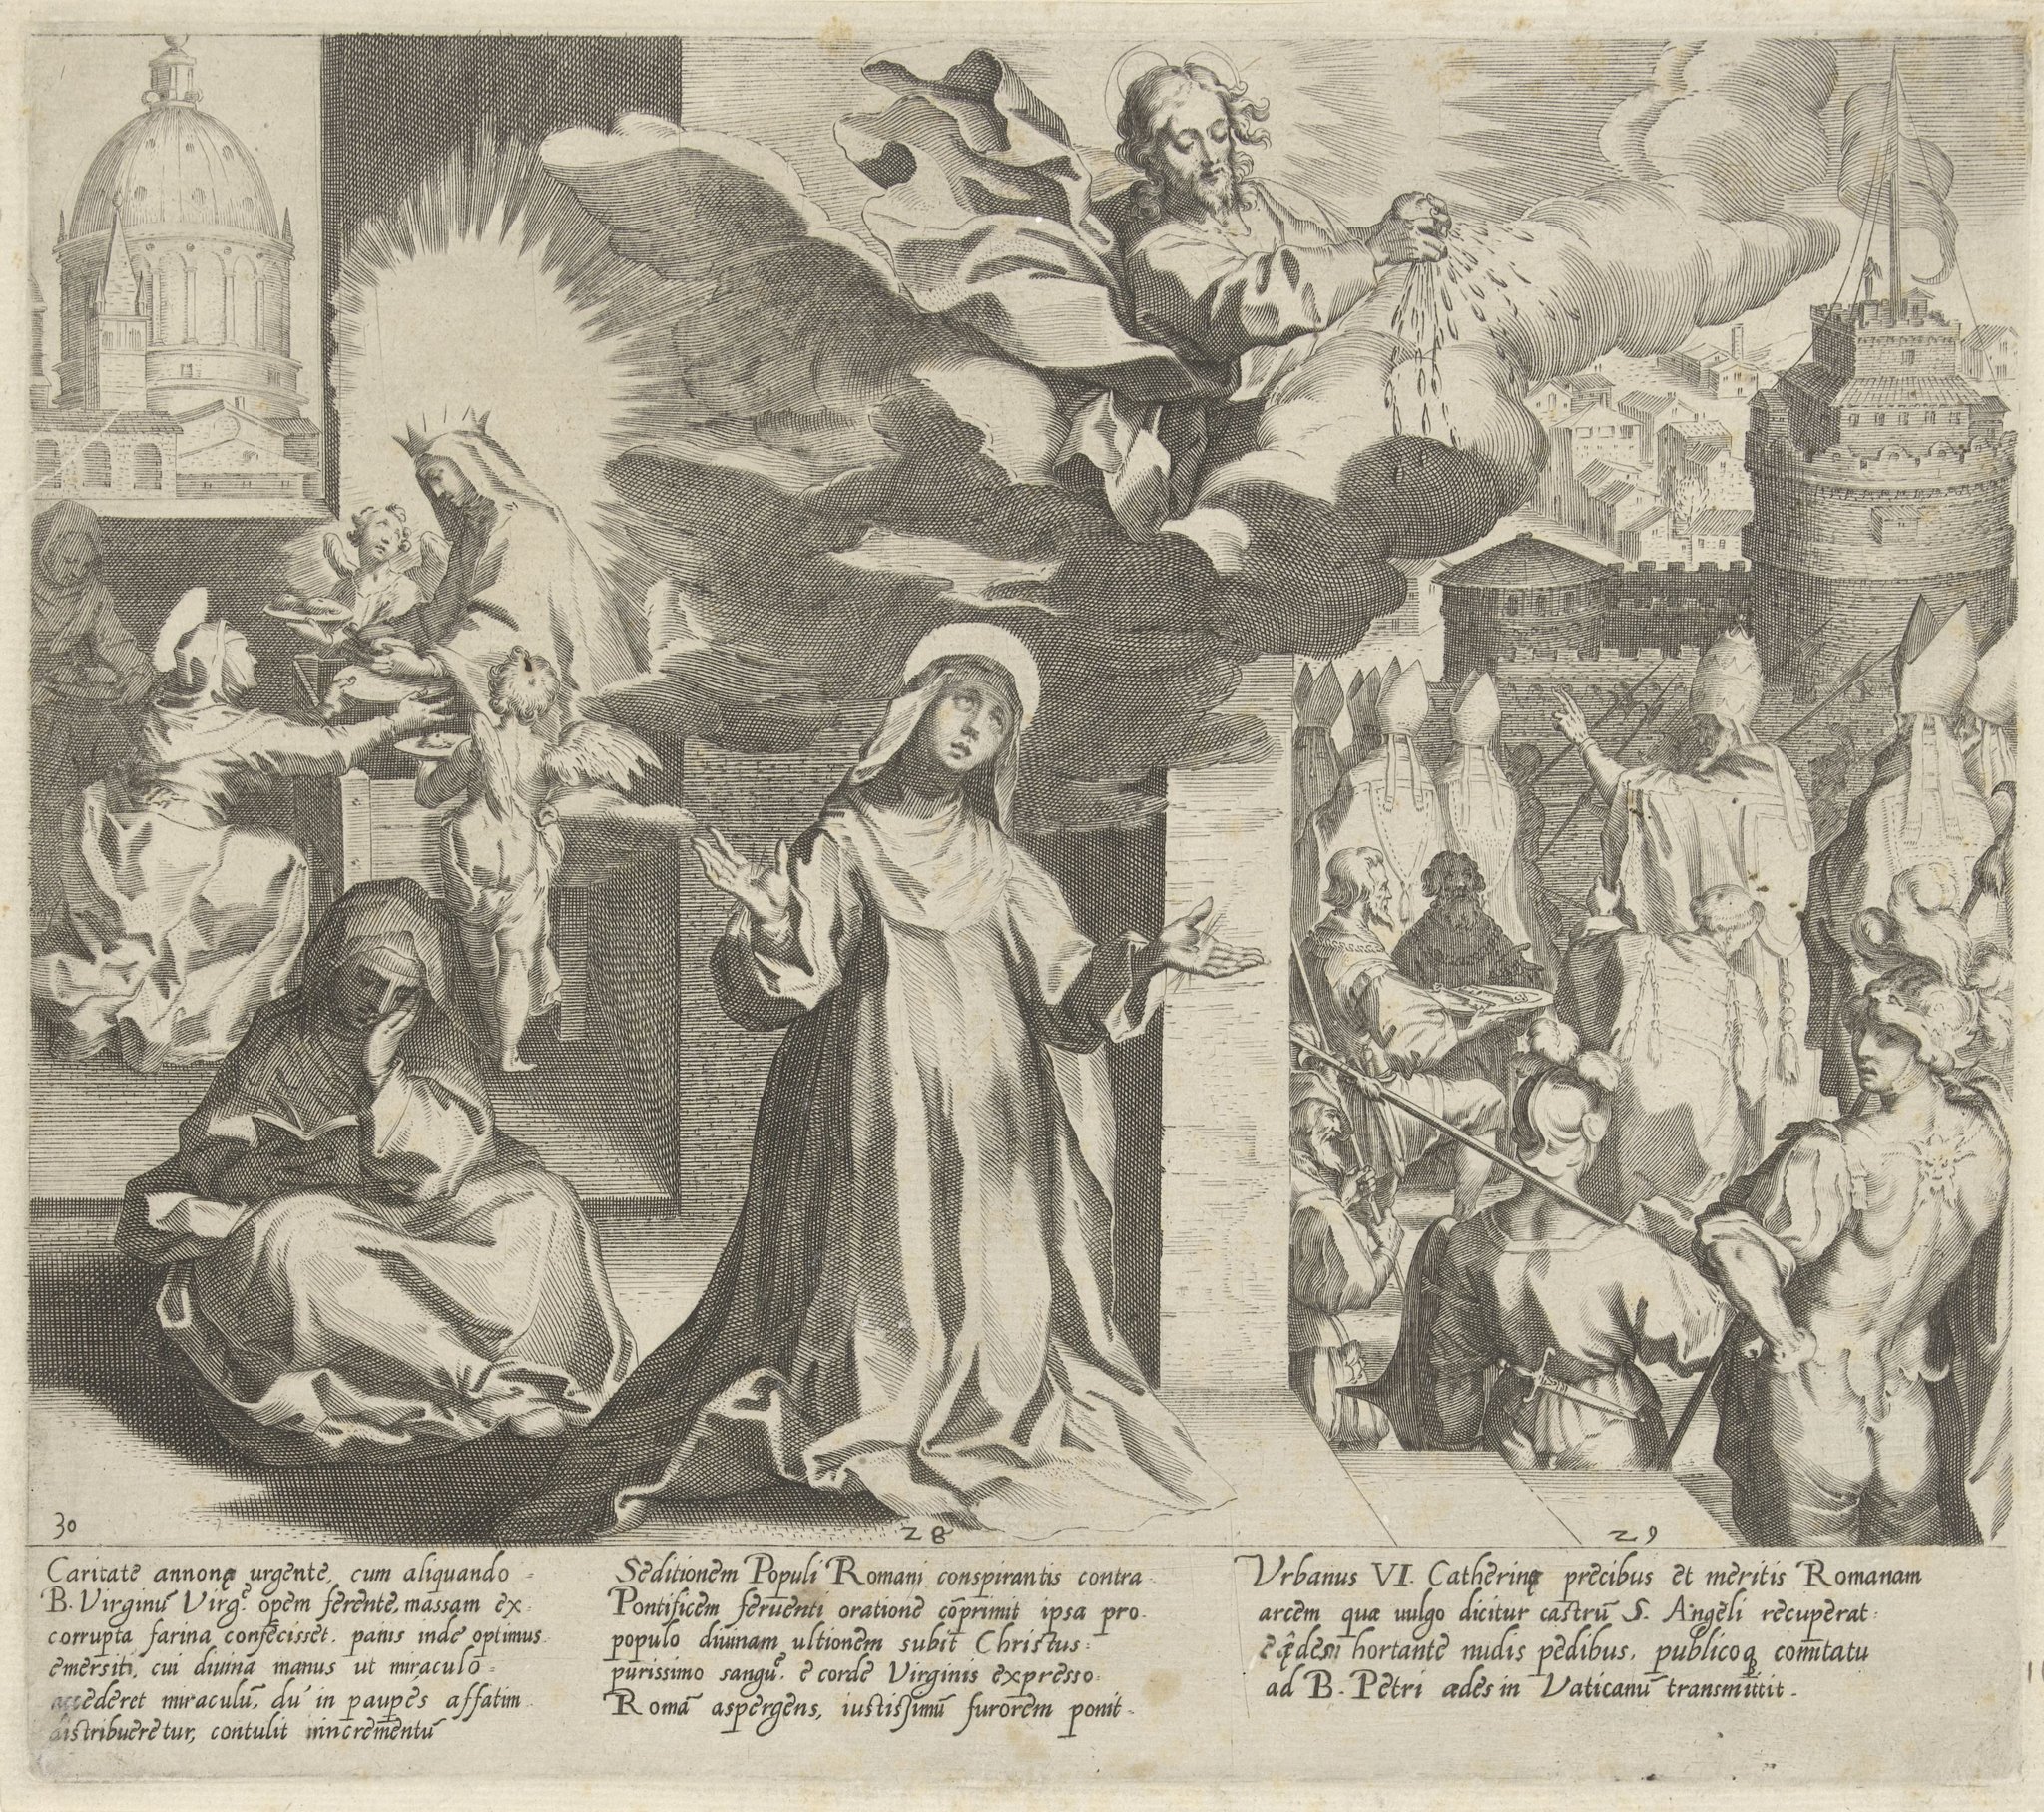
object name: print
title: Scènes uit het leven en wonderen van de Heilige Catharina van Siena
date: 1597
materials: paper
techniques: engraving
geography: italy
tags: the virgin and dominican tertiary, catherine of siena; possible attributes: book, cross, crown of thorns, crucifix, demon under foot, heart (with cross), lily, plague-stricken, ring, rosary, stigmata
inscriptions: inscription: ‘11’, collector's mark: Lugt 11, collector's mark: Lugt 10, collector's mark: ‘Hinloopen’